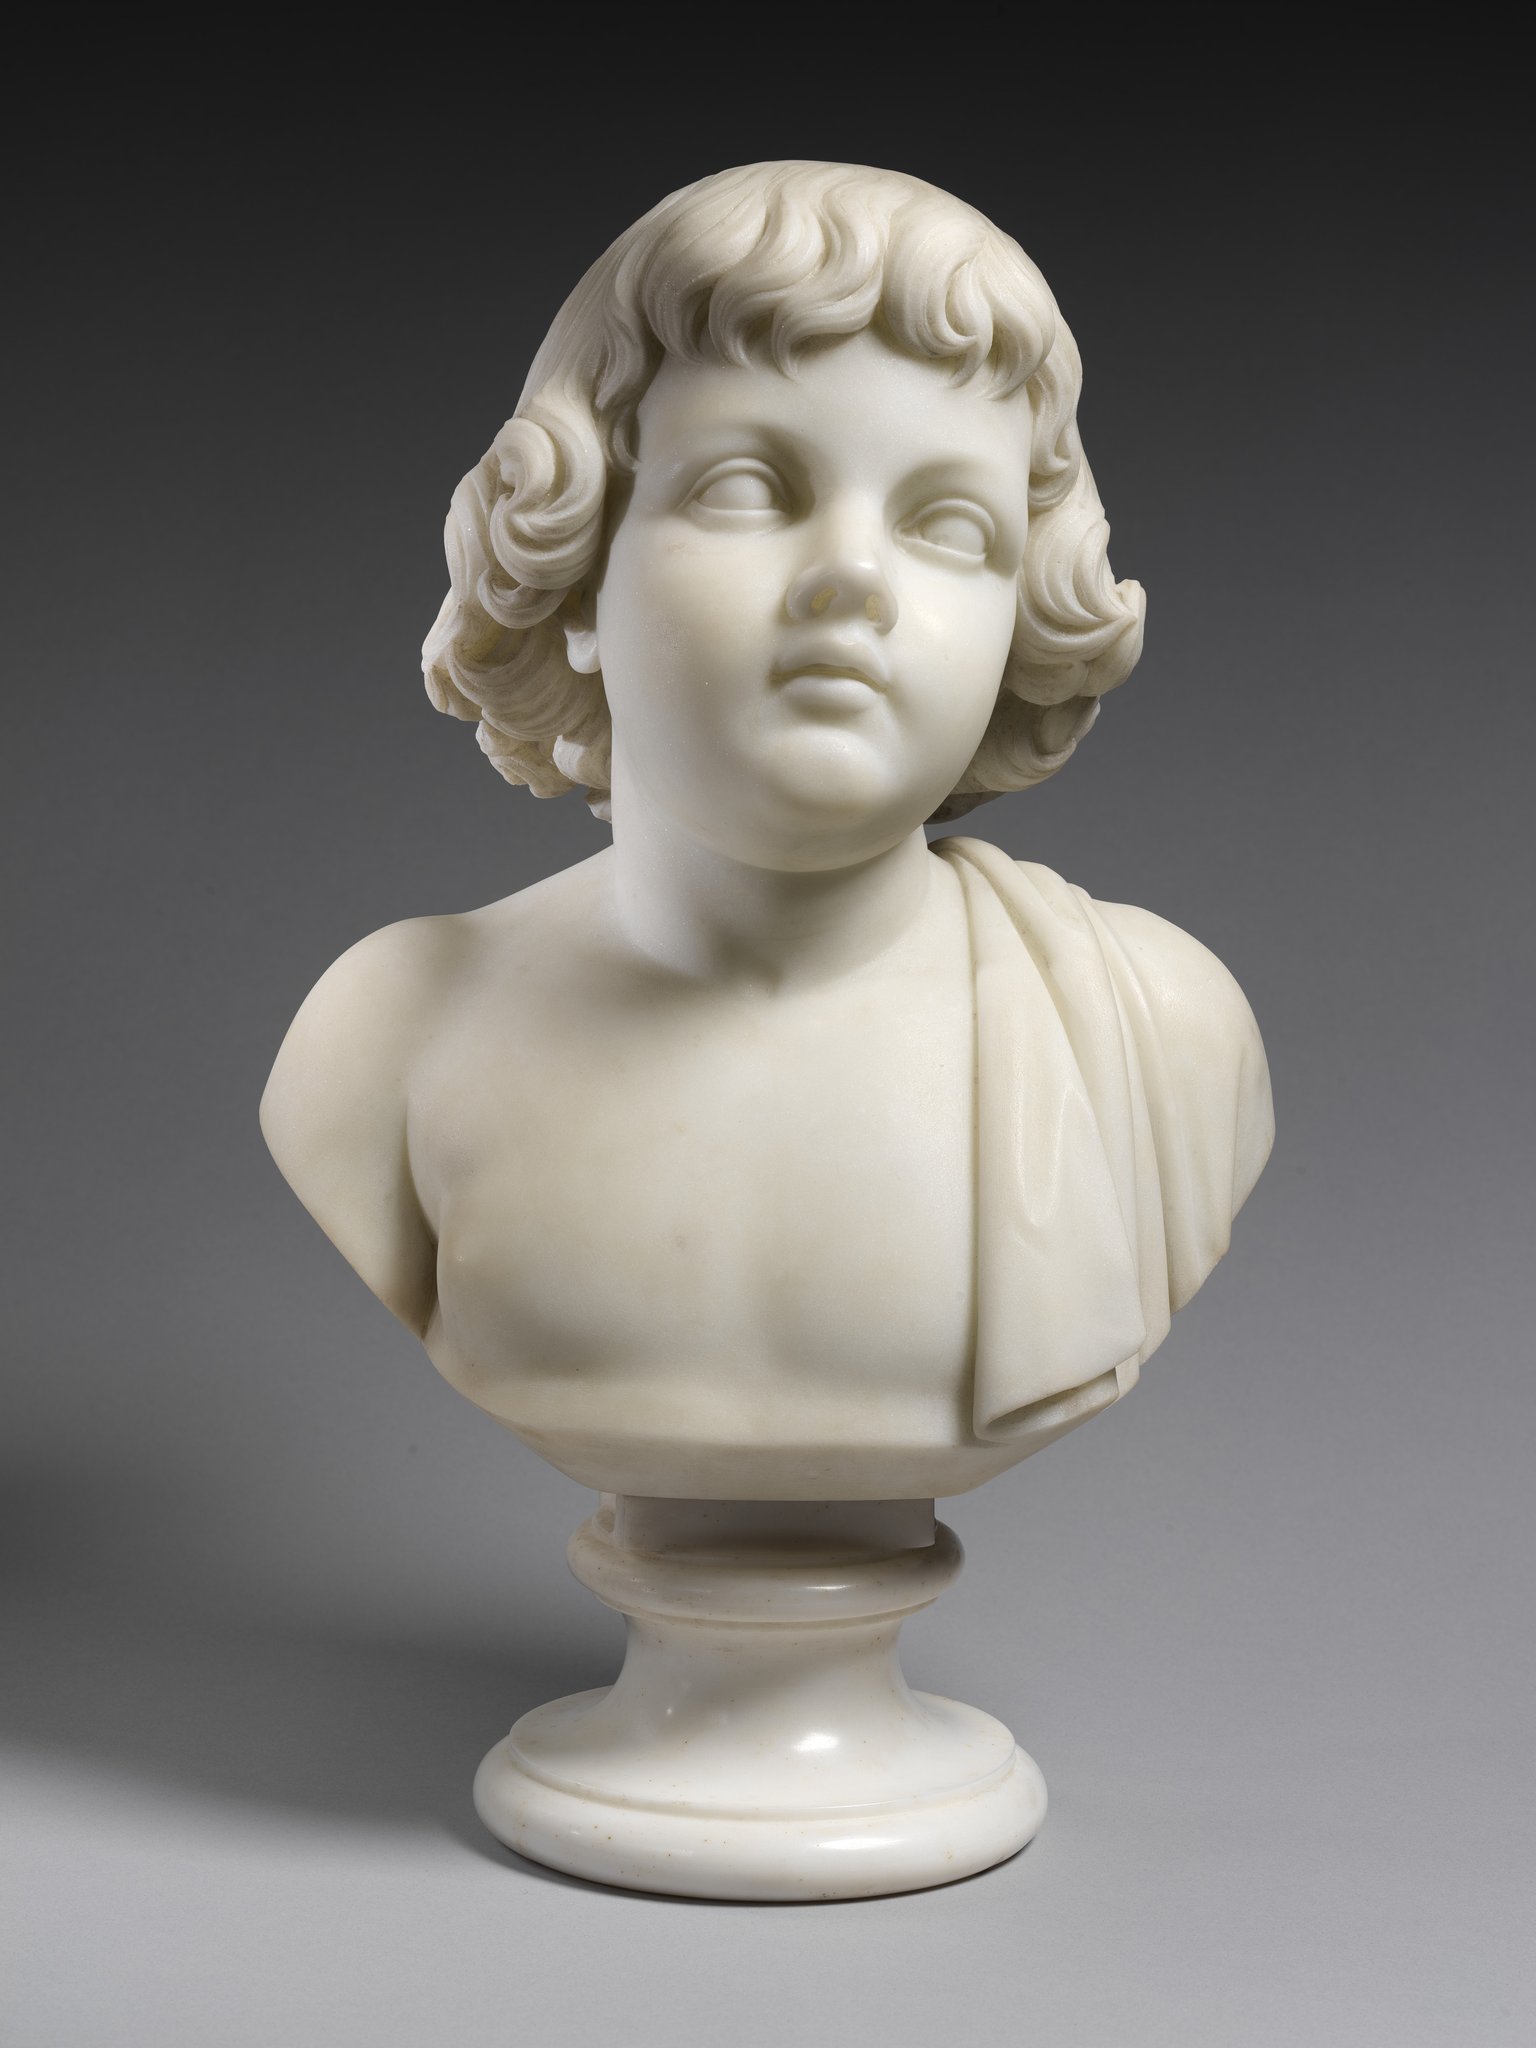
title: John Neal Tilton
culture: american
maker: emma stebbins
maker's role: artist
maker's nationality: american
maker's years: 1815-1882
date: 1865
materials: marble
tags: boys,portraits